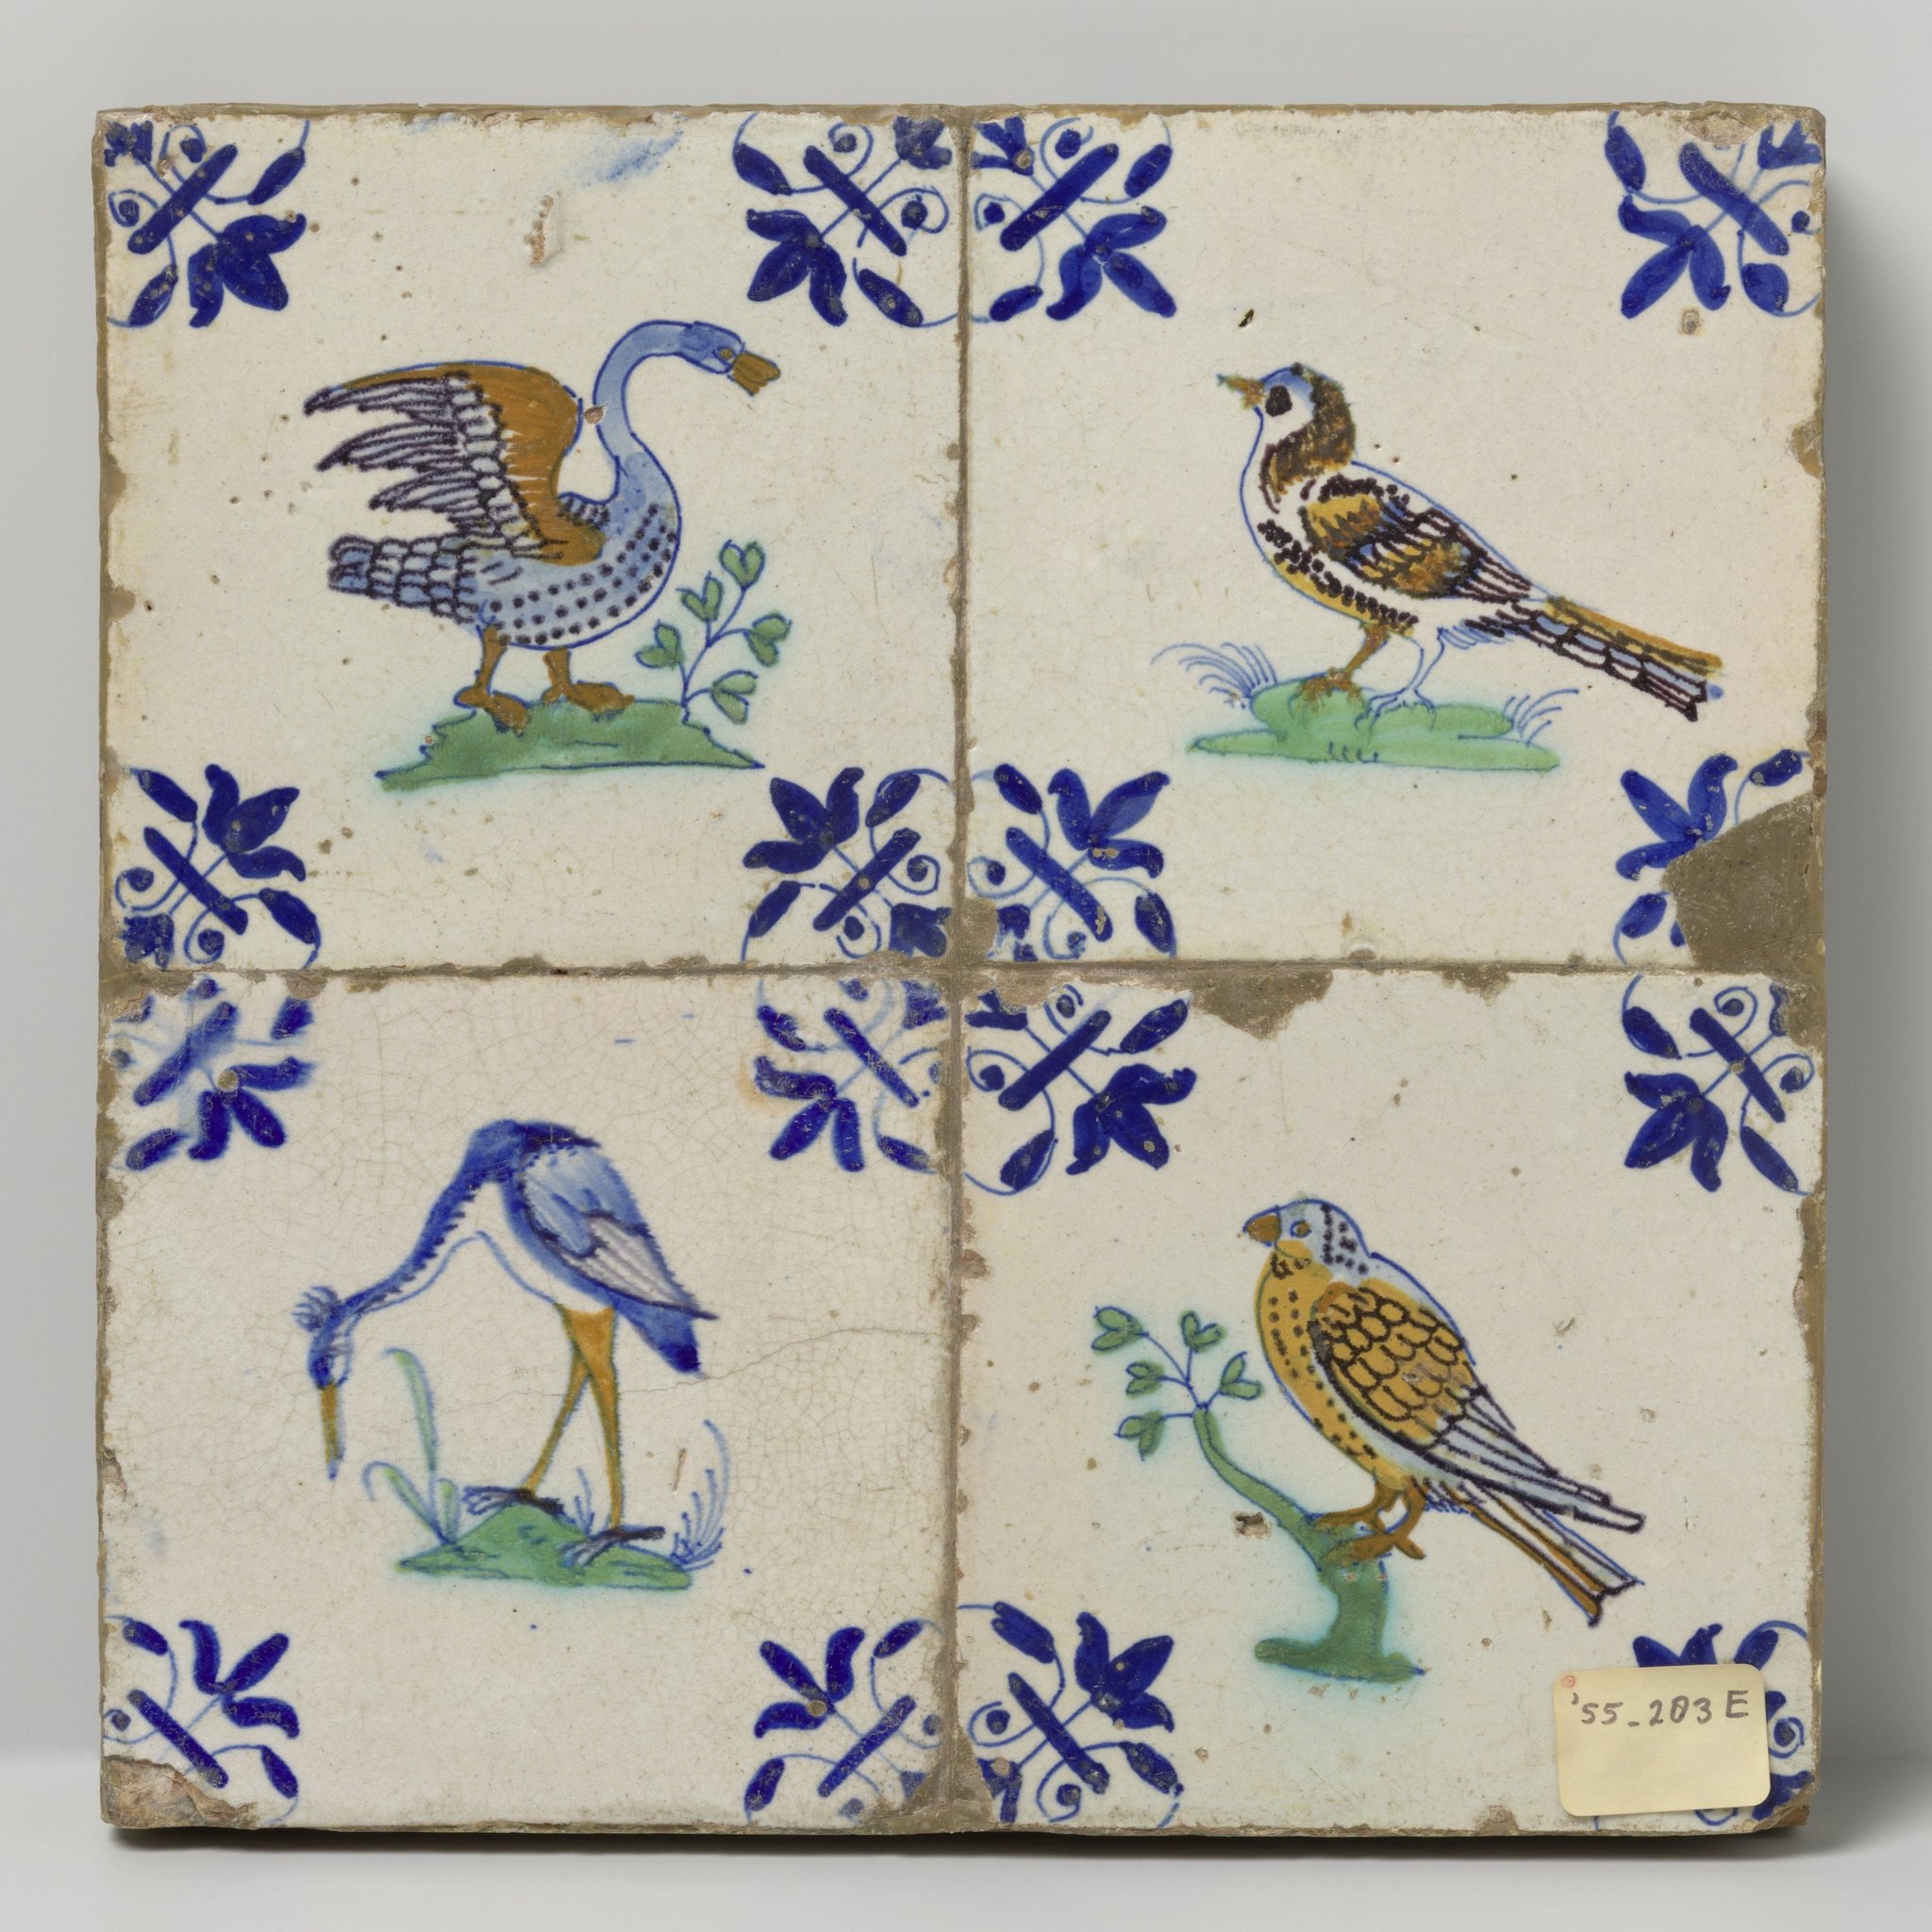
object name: tegelveld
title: Veld van vier tegels met vogels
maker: Anonymous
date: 1640-1660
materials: earthenware, glaze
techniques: maiolica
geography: netherlands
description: Veld van vier tegels (2 x 2) elk met een veelkleurig (blauw, groen, geel en oranje) geschilderde vogel op een grondje met in de hoeken een lelie.